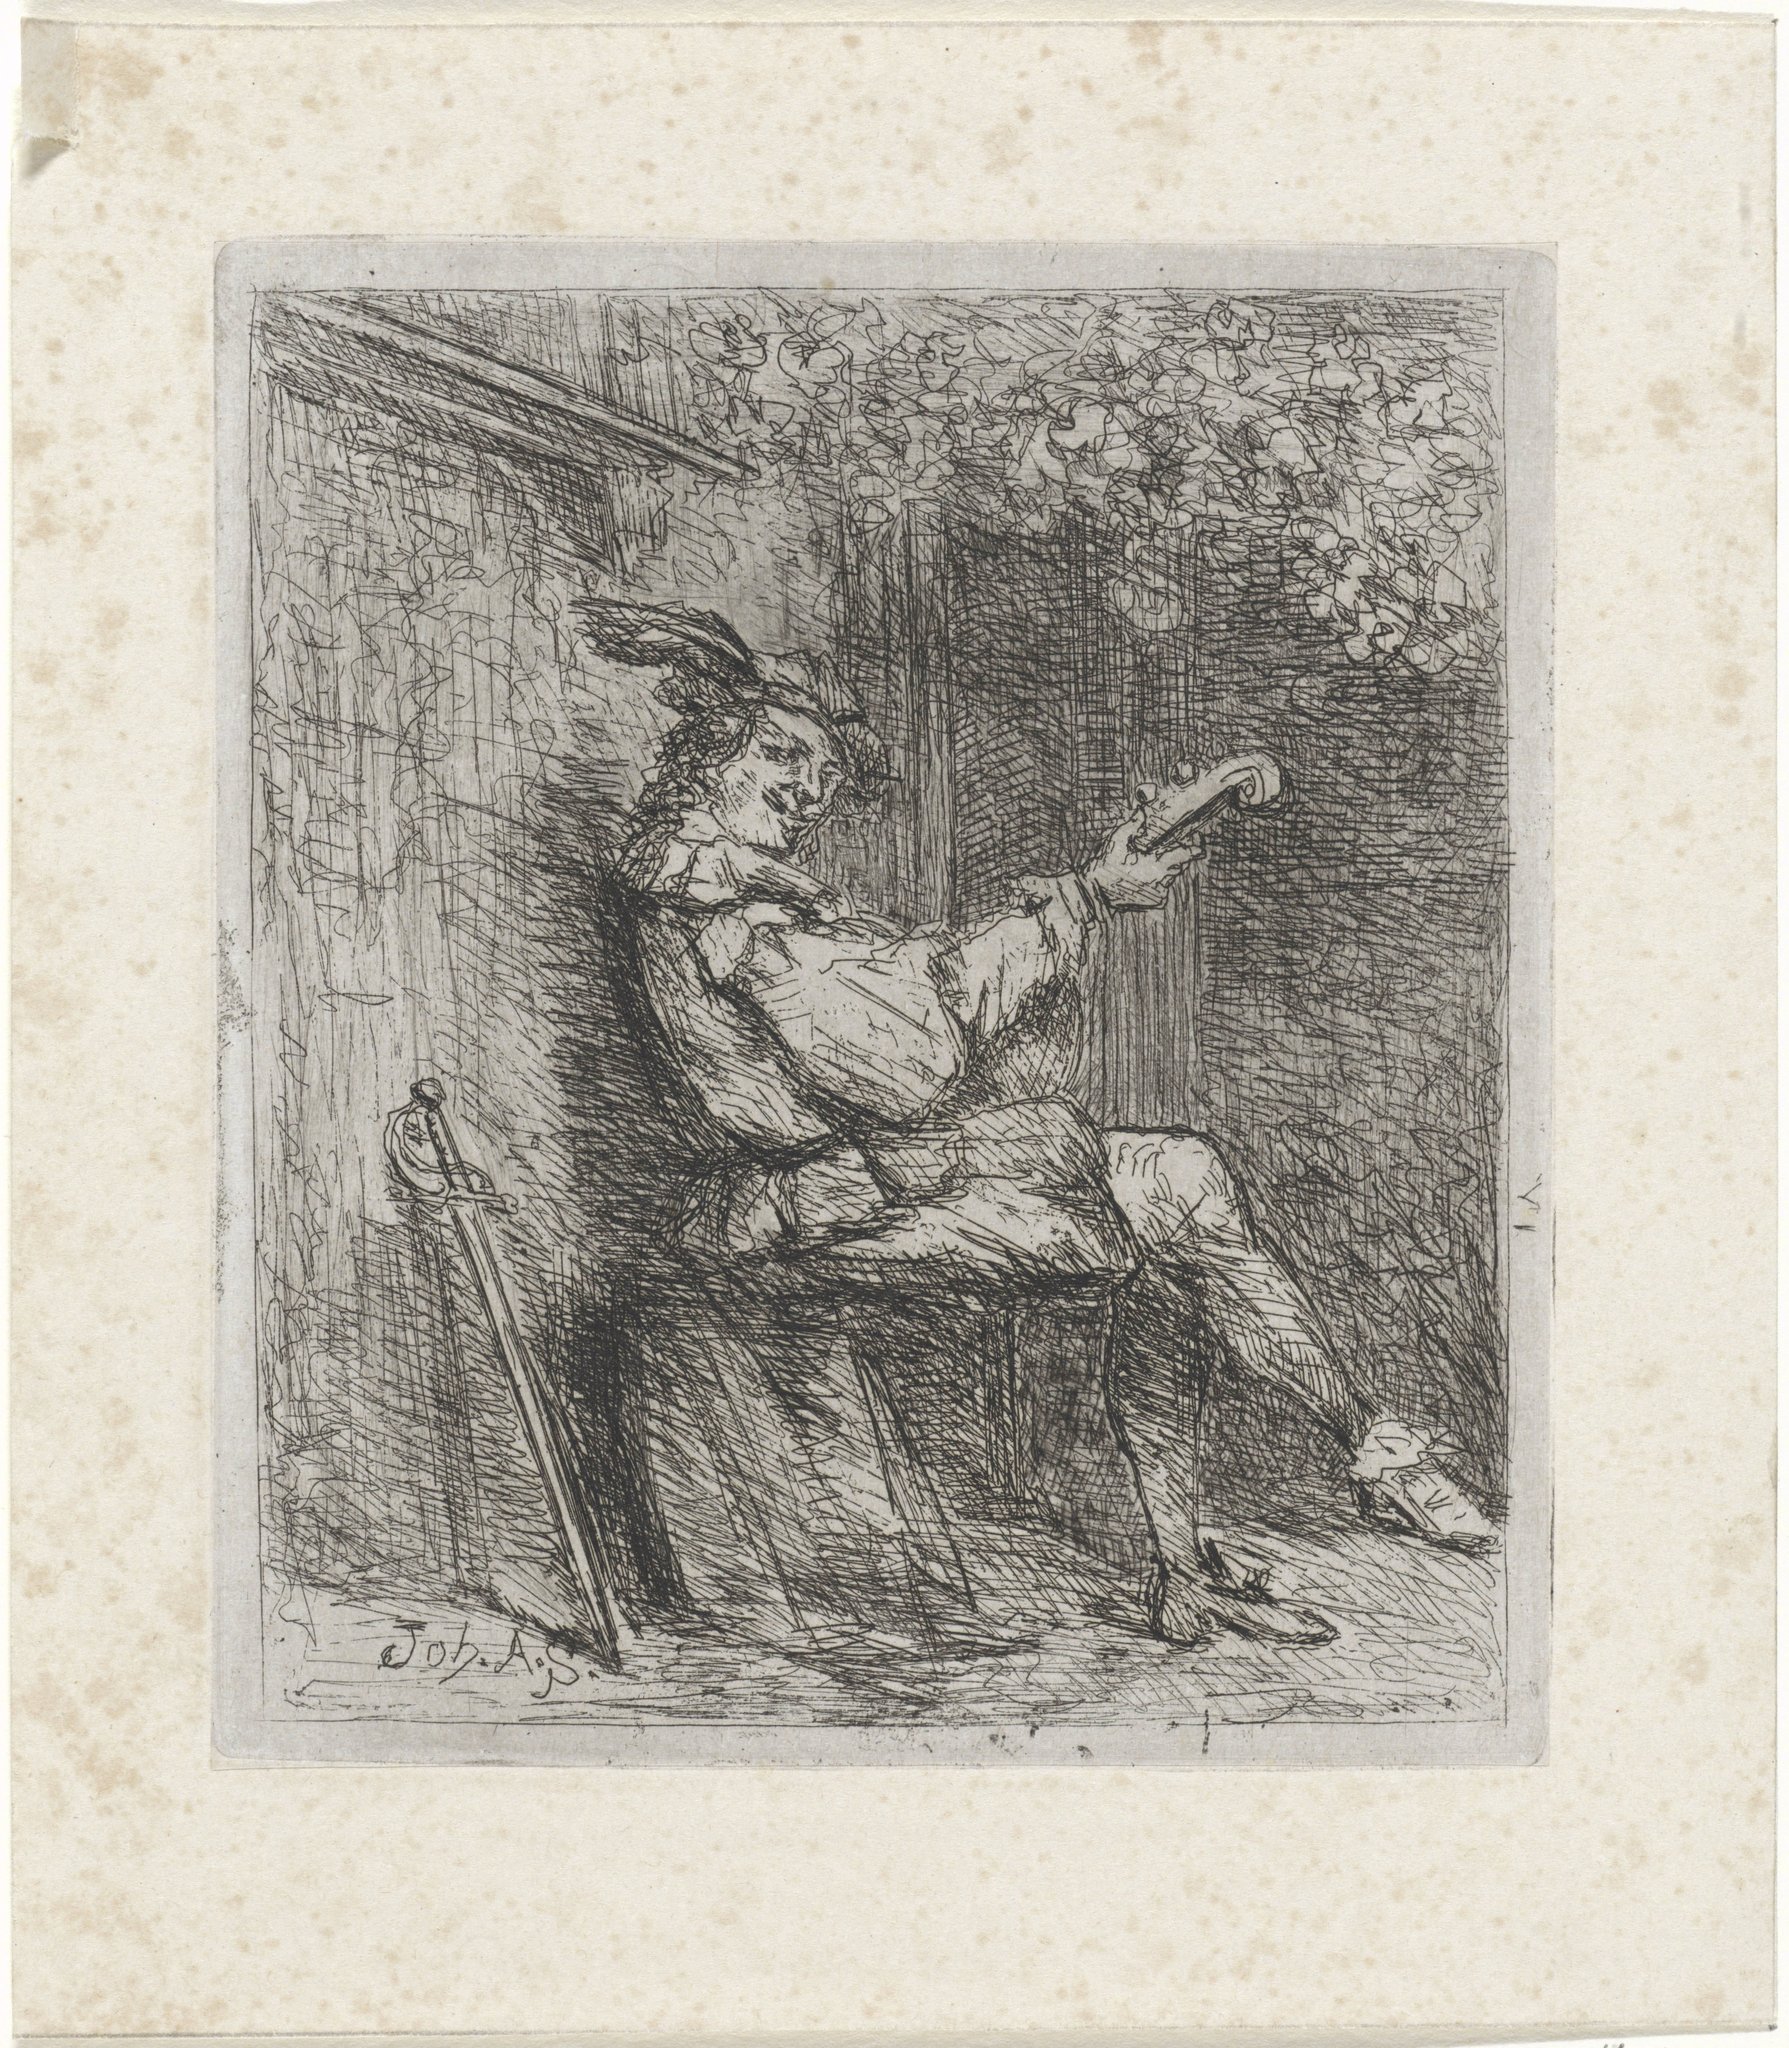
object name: print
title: Man met een luit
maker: johannes adrianus schultz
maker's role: print maker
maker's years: 1820-1863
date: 1830-1863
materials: paper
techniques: etching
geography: netherlands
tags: lute, and special forms of lute, e.g.: theorbo - cc - out of doors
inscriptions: collector's mark: Lugt 2228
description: Een man bespeelt de luit zittend op een bankje tegen een muur. Naast hem een sabel.